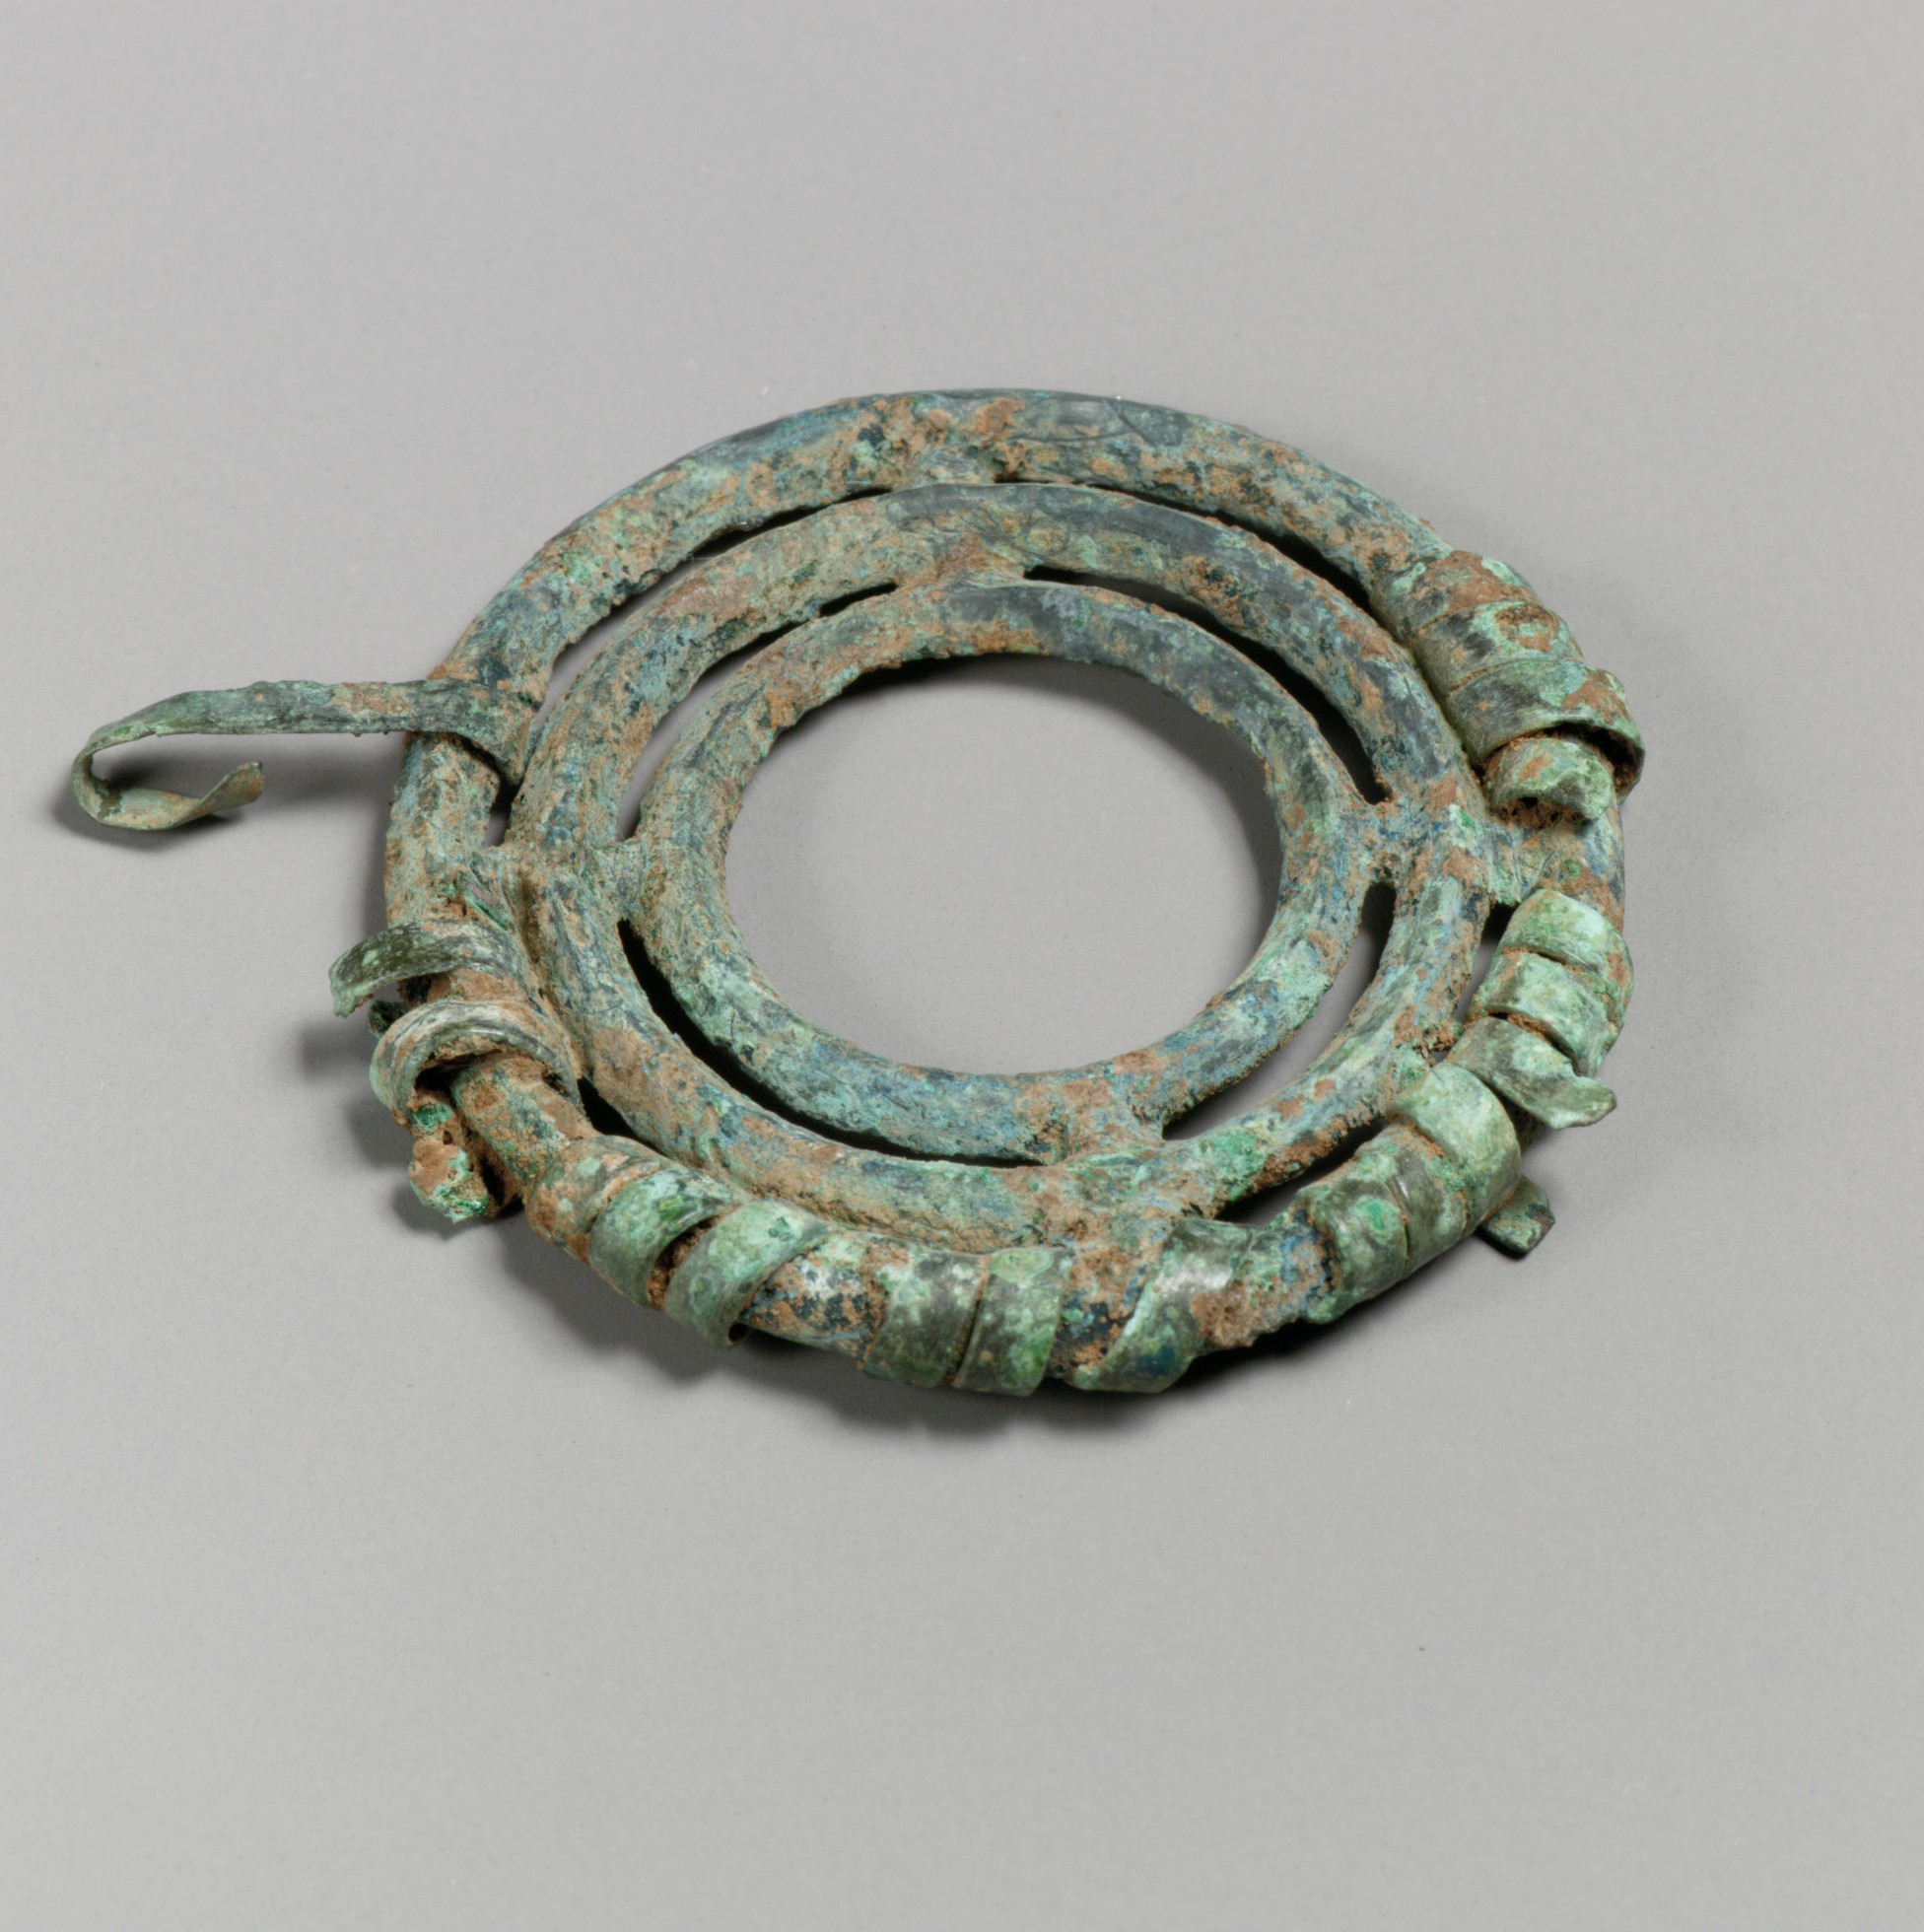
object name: necklace spiral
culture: italic, villanovan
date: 900-701 BCE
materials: bronze